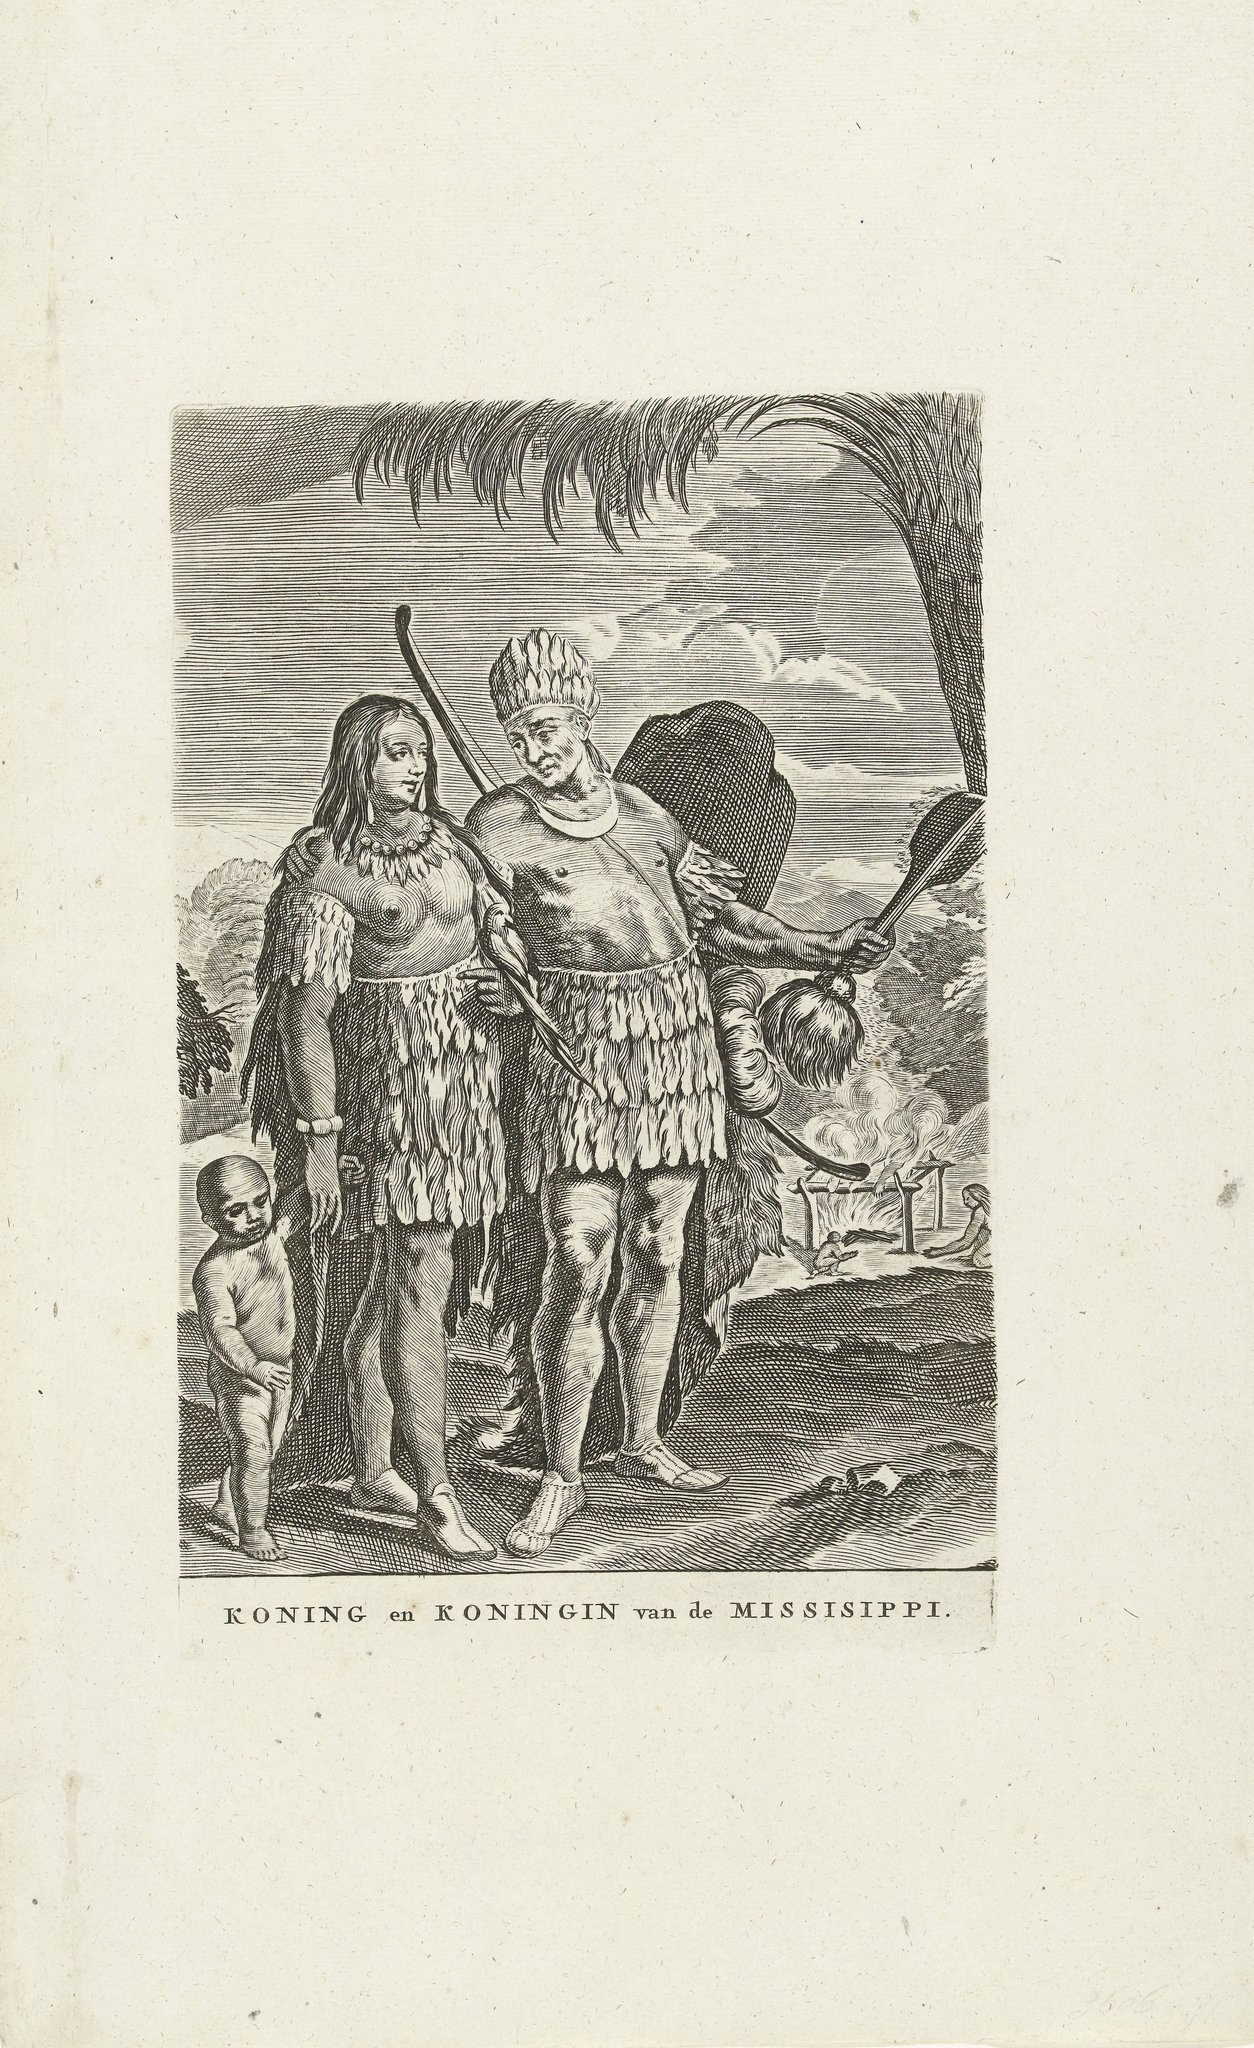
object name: print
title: Koning en Koningin van de Missisippi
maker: Anonymous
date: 1600-1650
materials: paper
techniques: engraving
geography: northern netherlands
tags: indigenous peoples of north america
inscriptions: collector's mark: Lugt 2228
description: Een echtpaar met kind, waarvan de man en vrouw aangeduid worden als de koning en koningin van de Mississippi, staat in een landschap. Op de achtergrond kannibalisme, het roosteren op een vuur van menselijke ledematen. Gebruikt als verwijzing naar de Mississippi-compagnie. Prent 71 in de serie Het Groote Tafereel der Dwaasheid met spotprenten op de Windhandel of Actiehandel van 1720.